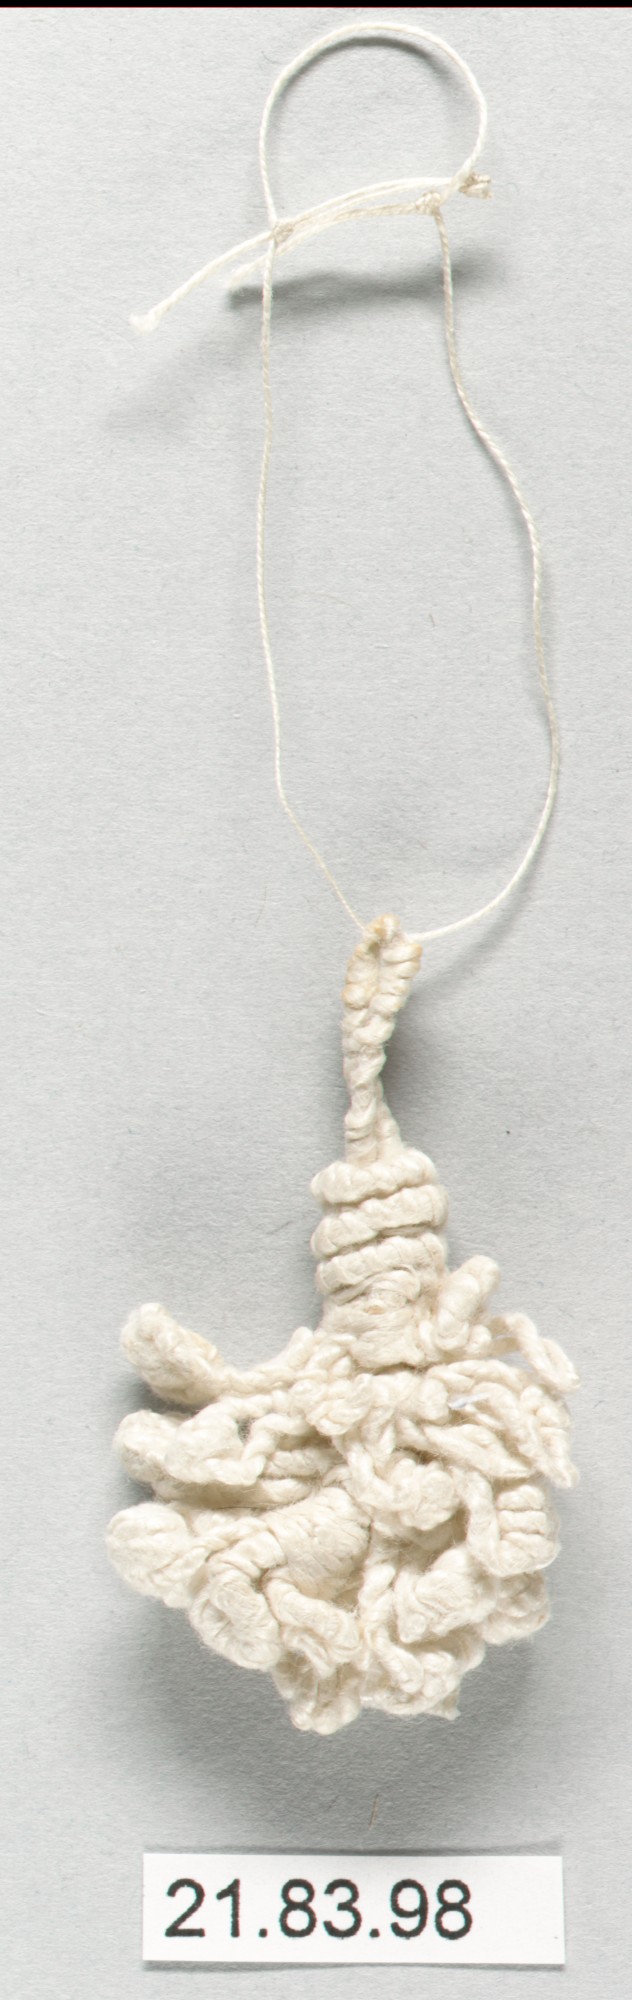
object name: tassel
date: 1601-1700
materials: linen